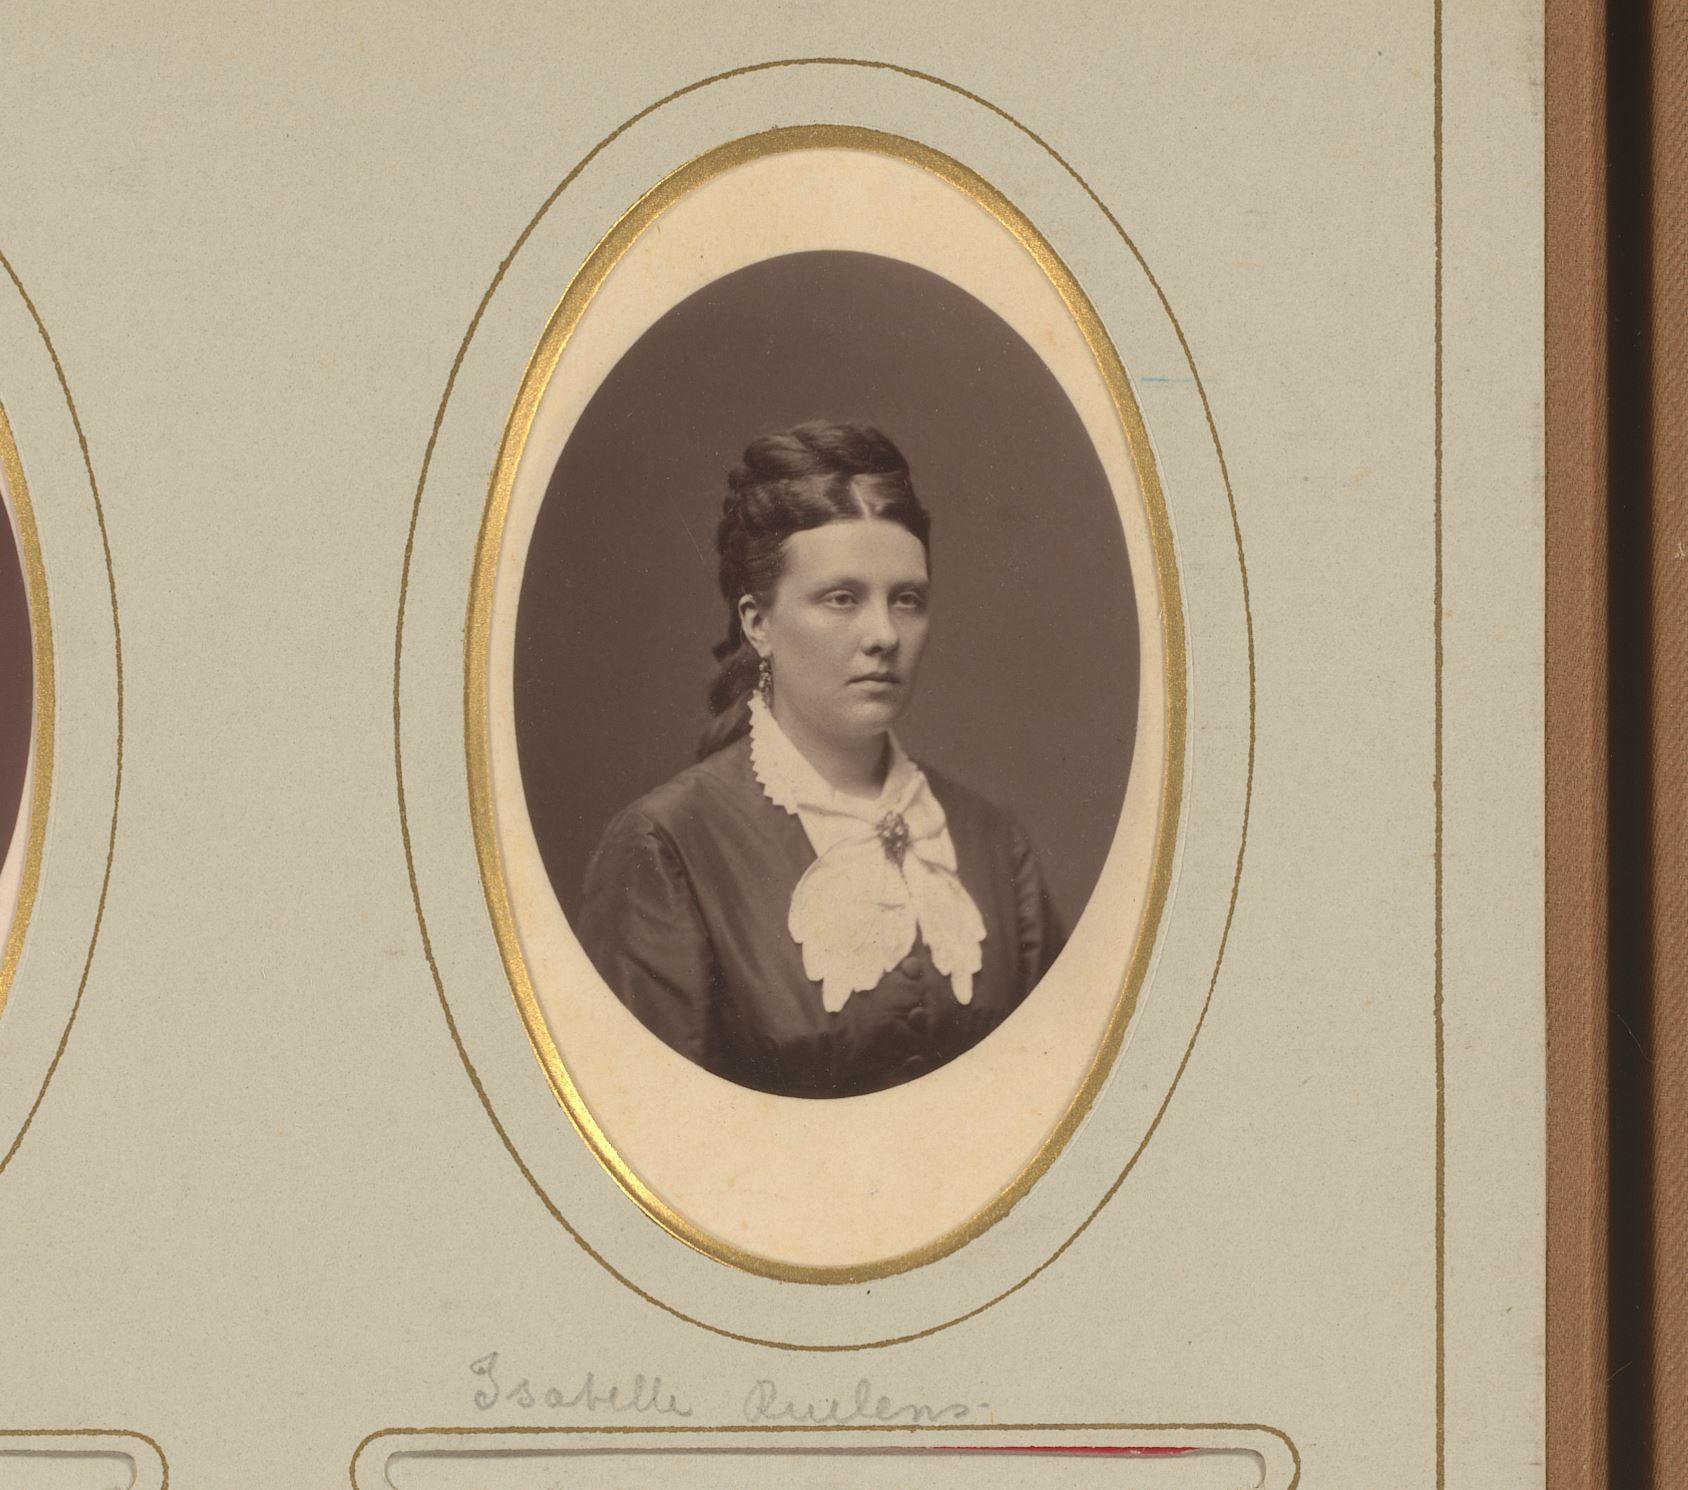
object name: album leaf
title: Portret van een vrouw, aangeduid als Isabelle Rubens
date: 1866-1890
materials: cardboard, paper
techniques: carbon print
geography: brussels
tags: historical persons - bb - woman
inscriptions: inscription: ‘Procédé inaltérable/ Photographie au Charbon/ (...)/ Géruzet Frères/ Photographes de S.M. la Reine des Belges/ 27b. Rue de l'Ecuyer/ Bruxelles’, name: ‘Isabelle Rubens’